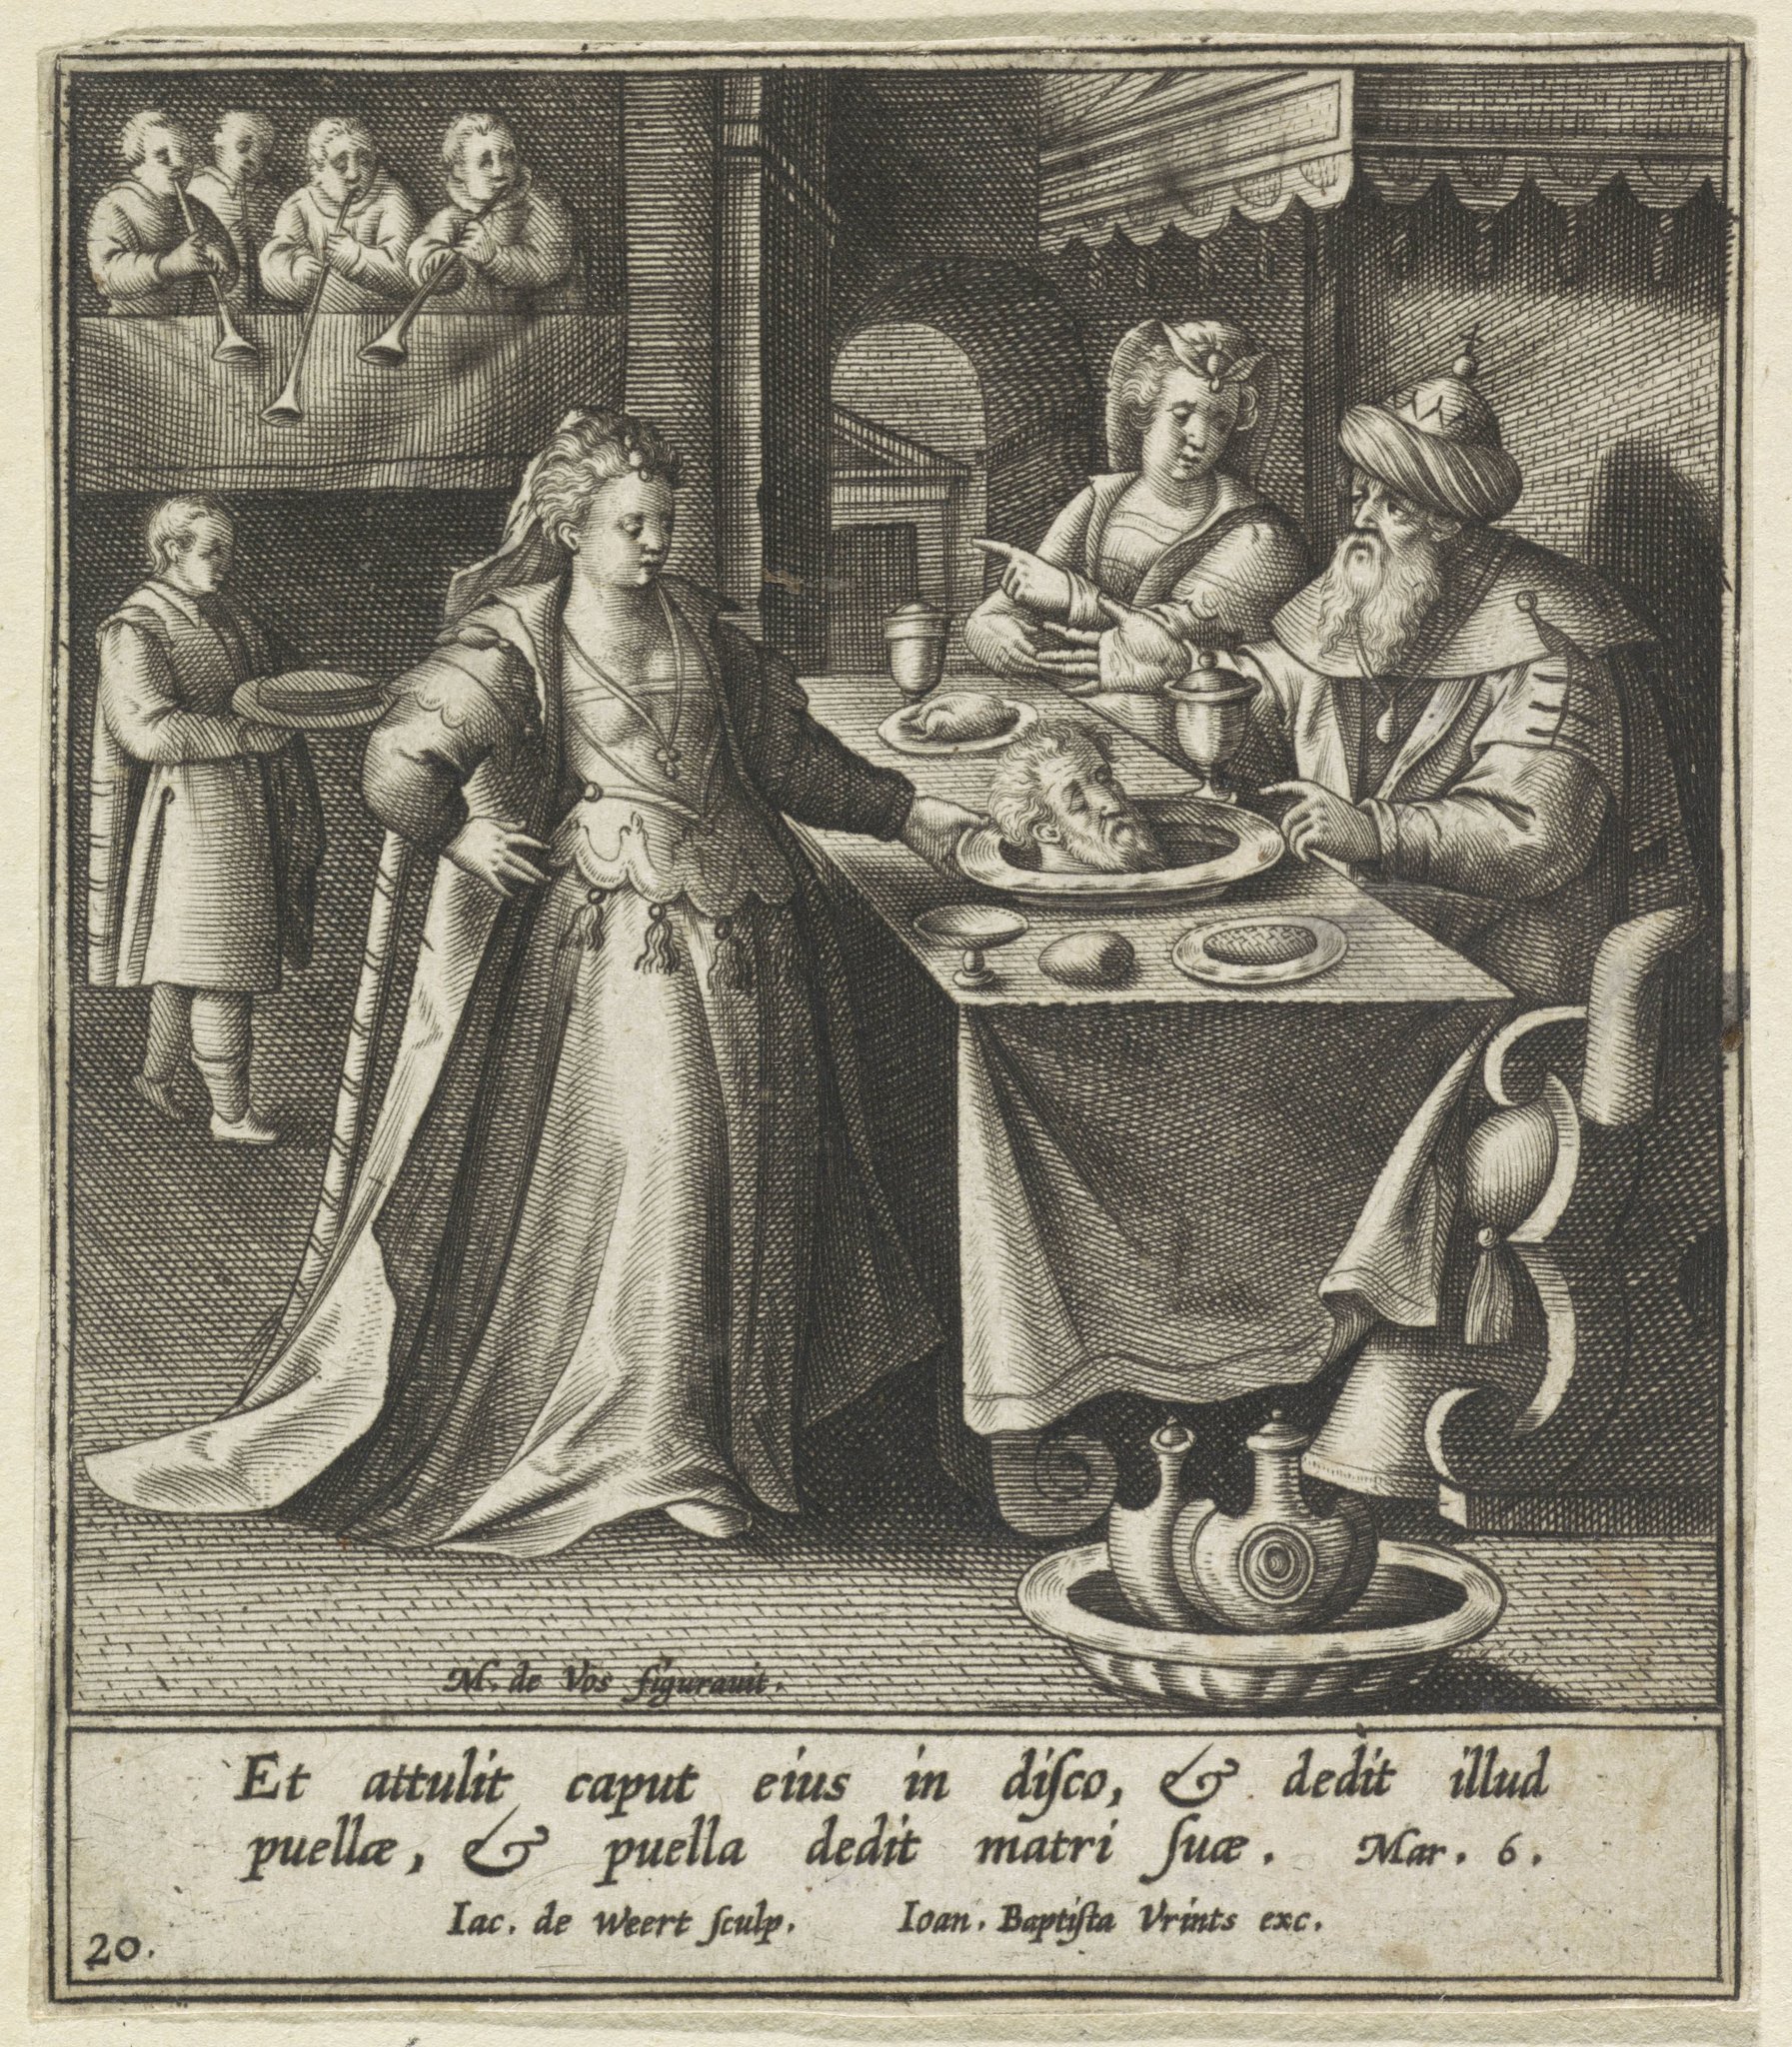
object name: print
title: Leven van Johannes de Doper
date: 1580-1600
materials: paper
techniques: engraving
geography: antwerp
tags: horn, trumpet, cornet, trombone, tuba, the head of john the baptist brought to or lying on the banqueting table, salome gives the head of john the baptist to her mother, salome with the head of john the baptist on a dish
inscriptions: collector's mark: Lugt 240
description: Herodes en Herodias zitten achter een gedekte tafel onder een baldakijn. Salome staat aan de andere kant van de tafel en biedt het hoofd van Johannes de Doper op een schotel aan haar ouders aan. Achter hen staat een bediende voor een loggia met bazuinspelers. Onder de voorstelling bevindt zich een tweeregelige, Latijnse tekst met de beschrijving van de scène uit Mar. 6.